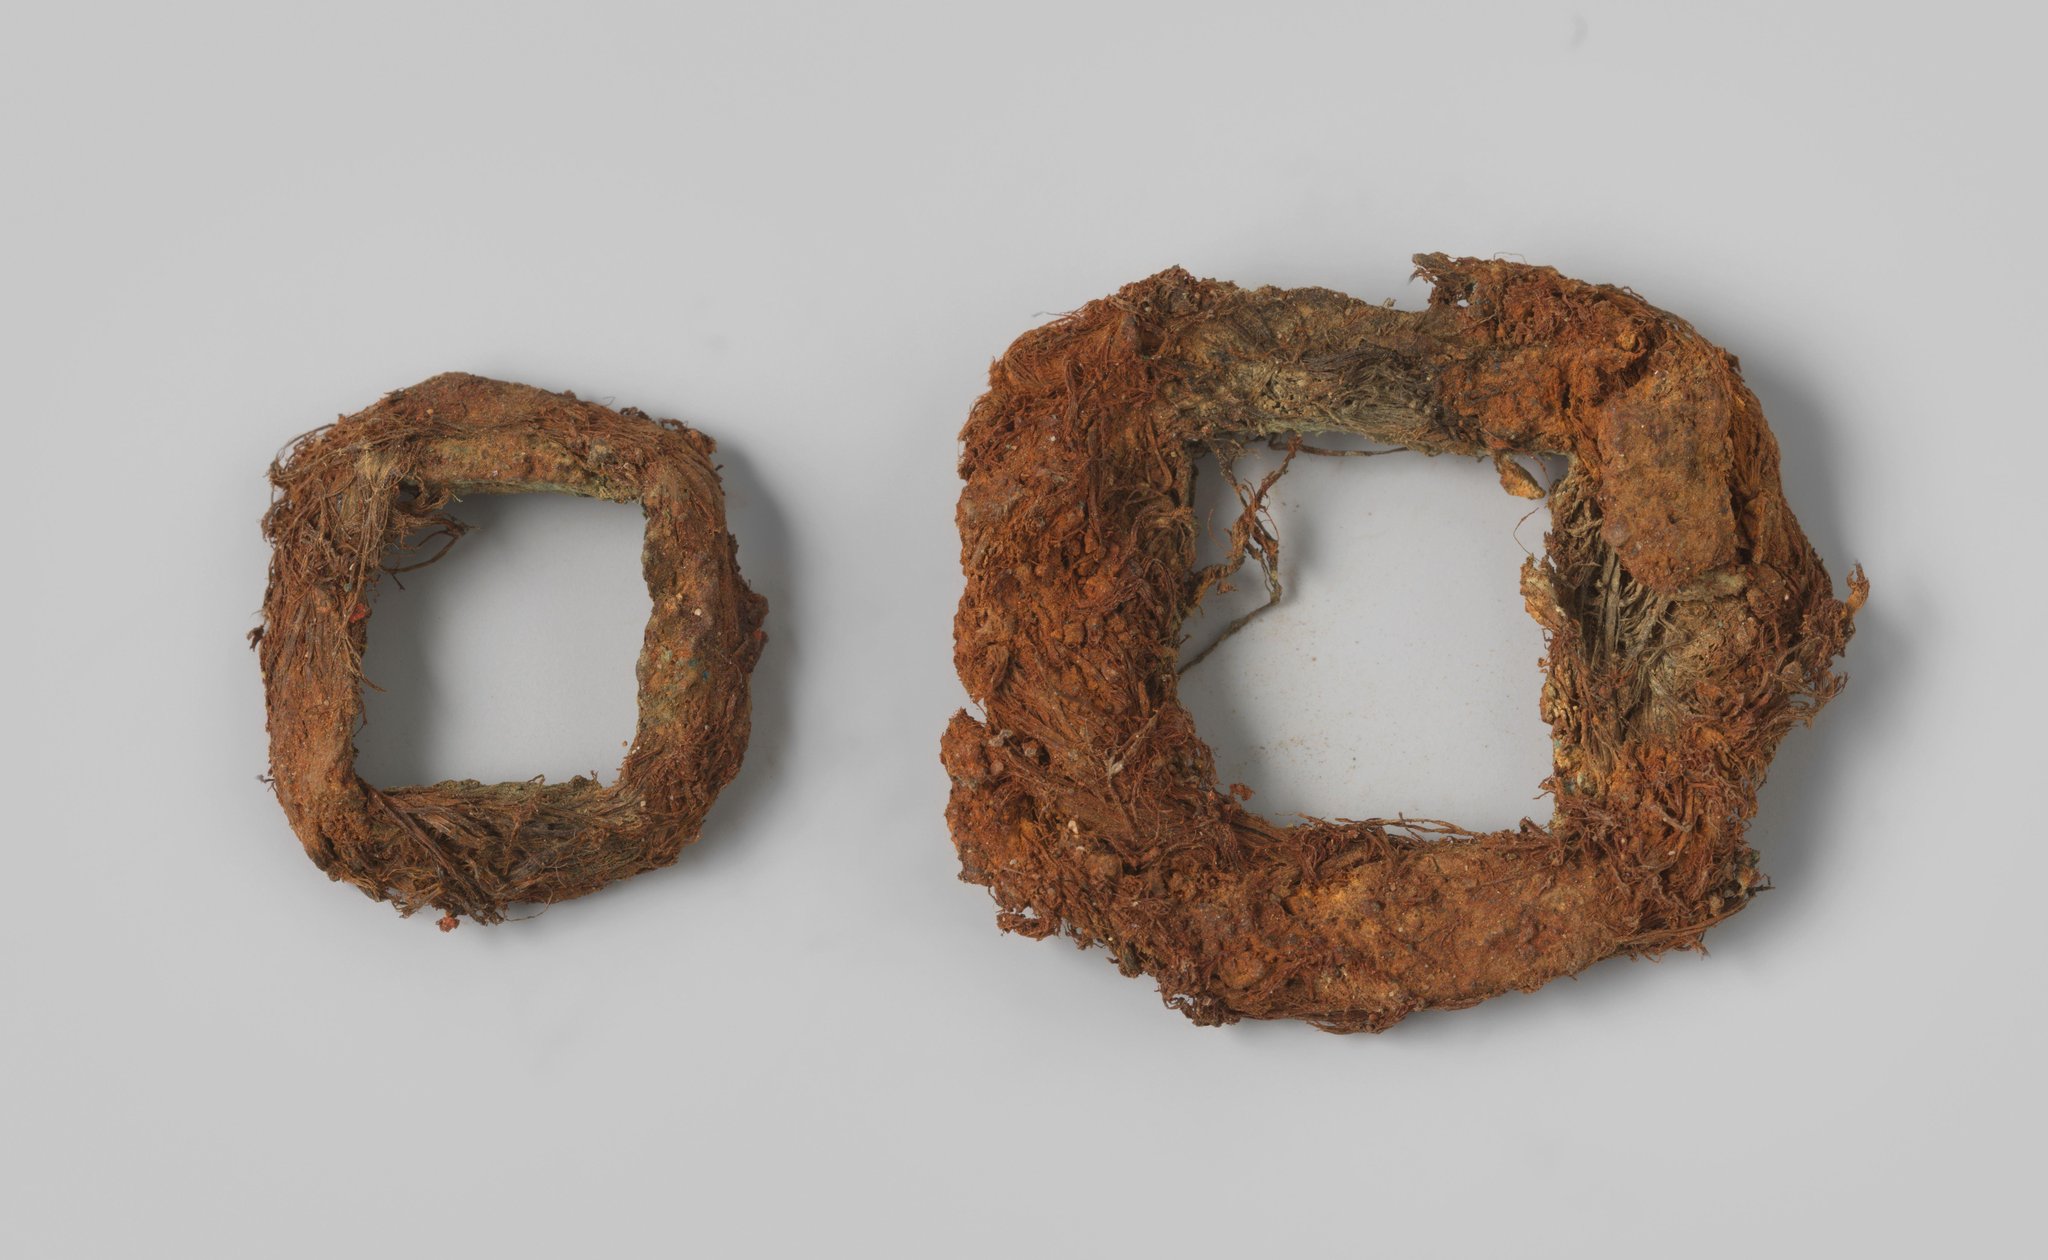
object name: hilt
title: Sluitringen van een gevest uit het wrak van de Oost-Indiëvaarder Hollandia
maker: Anonymous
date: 1700-1743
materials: fiber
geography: netherlands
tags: verenigde oostindische compagnie, hollandia (schip), annet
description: Hilt, washer, oval, bevelled outer edge, flat, square central hole: oval, flat, straight edges, square central hole.